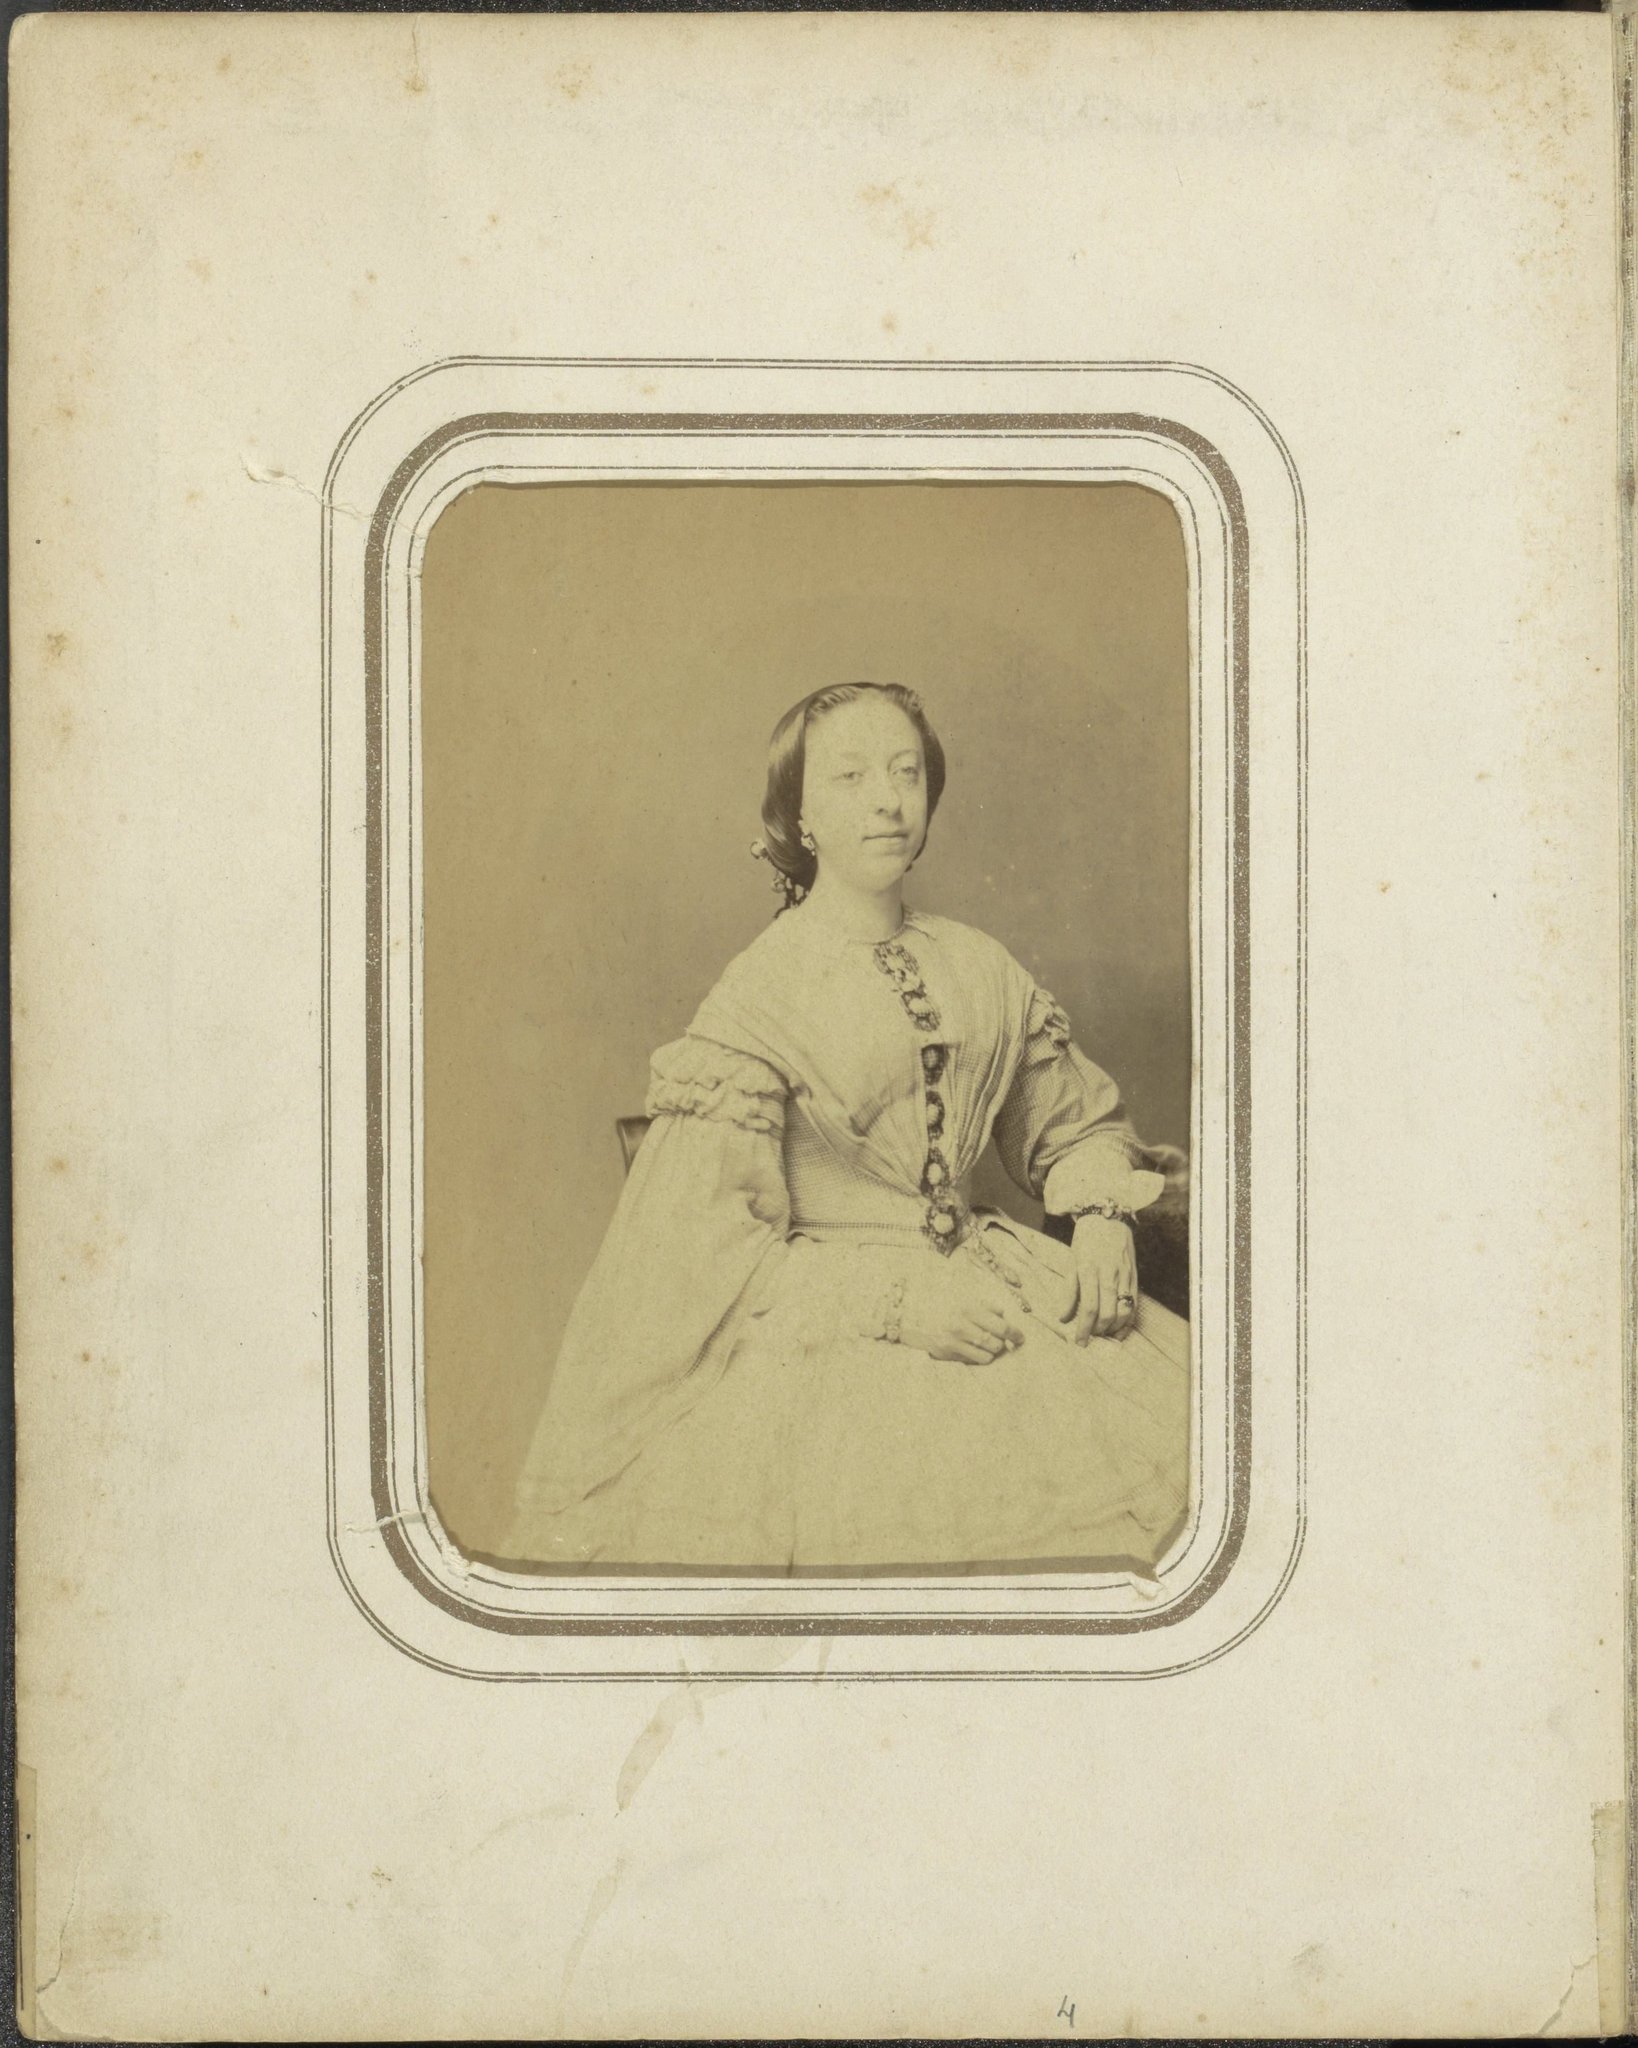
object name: photograph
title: Portret van een vrouw in een jurk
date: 1860-1880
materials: cardboard, photographic support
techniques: albumen print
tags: studio requisites ~ photographer, historical persons, styles of hairdress - aa - ~ women, family, relationship, descent, dress, gown, netherlands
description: Onderdeel van Familiealbum van H.W.F. Ligtenberg en L.M. Swart met 149 foto's en cartes-de-visite.